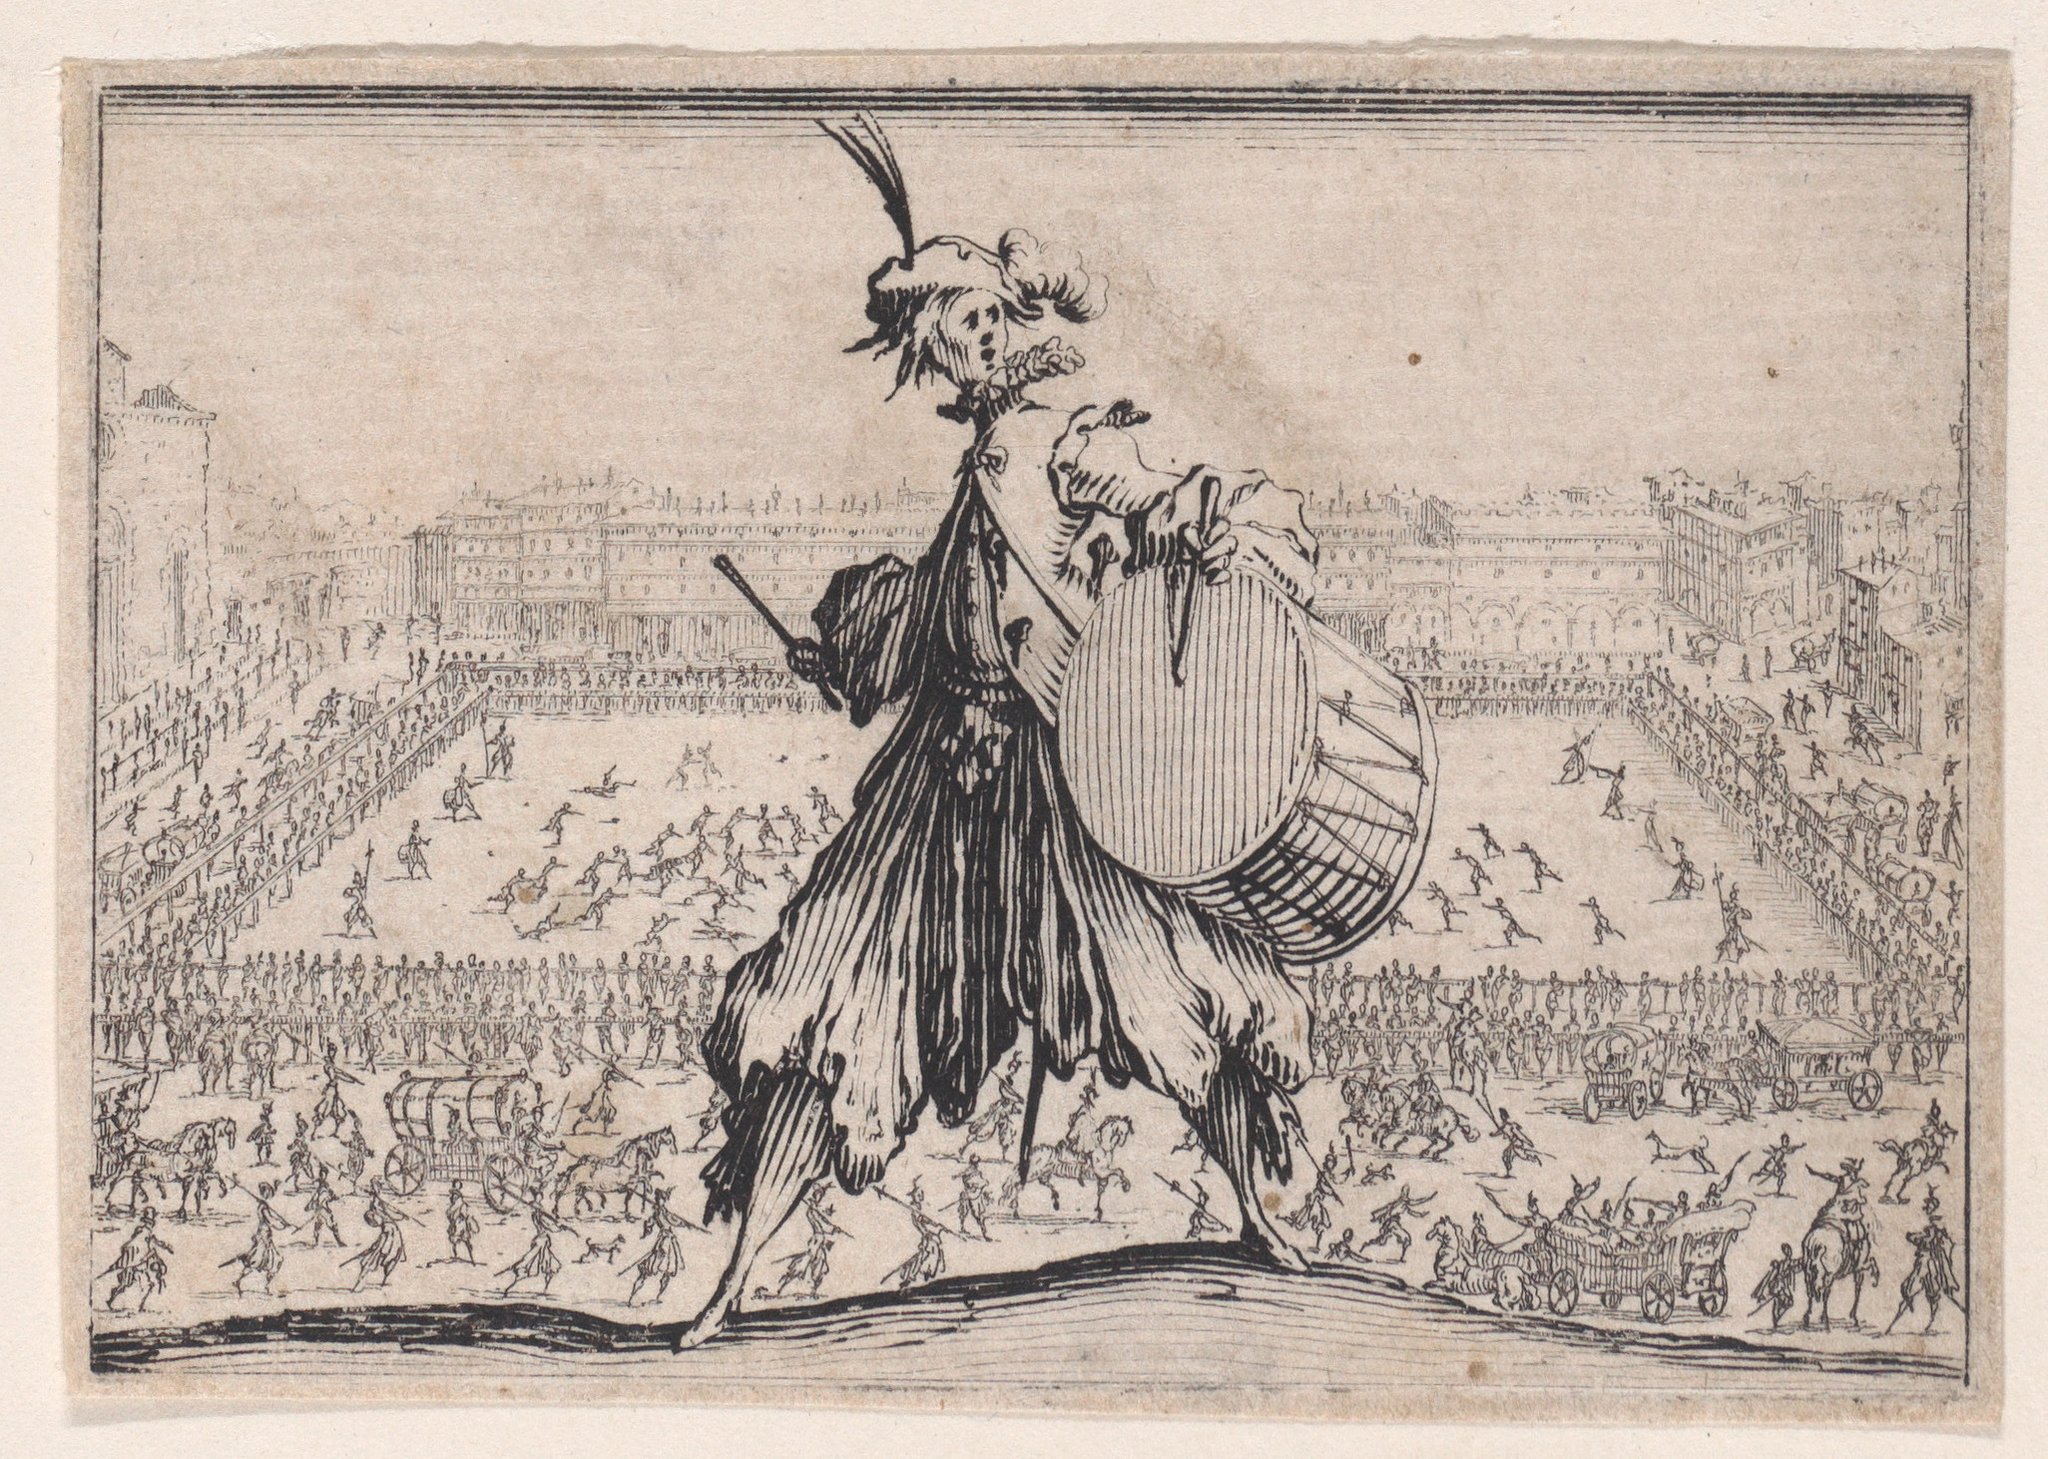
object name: print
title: Le Jeu de Paume sur la Place Sainte-Croix, a Florence (The Tennis Game on the Piazza Santa Croce in Florence), from Les Caprices Series A, The Florence Set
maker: jacques callot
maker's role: artist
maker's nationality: french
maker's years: 1592-1635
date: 1617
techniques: etching